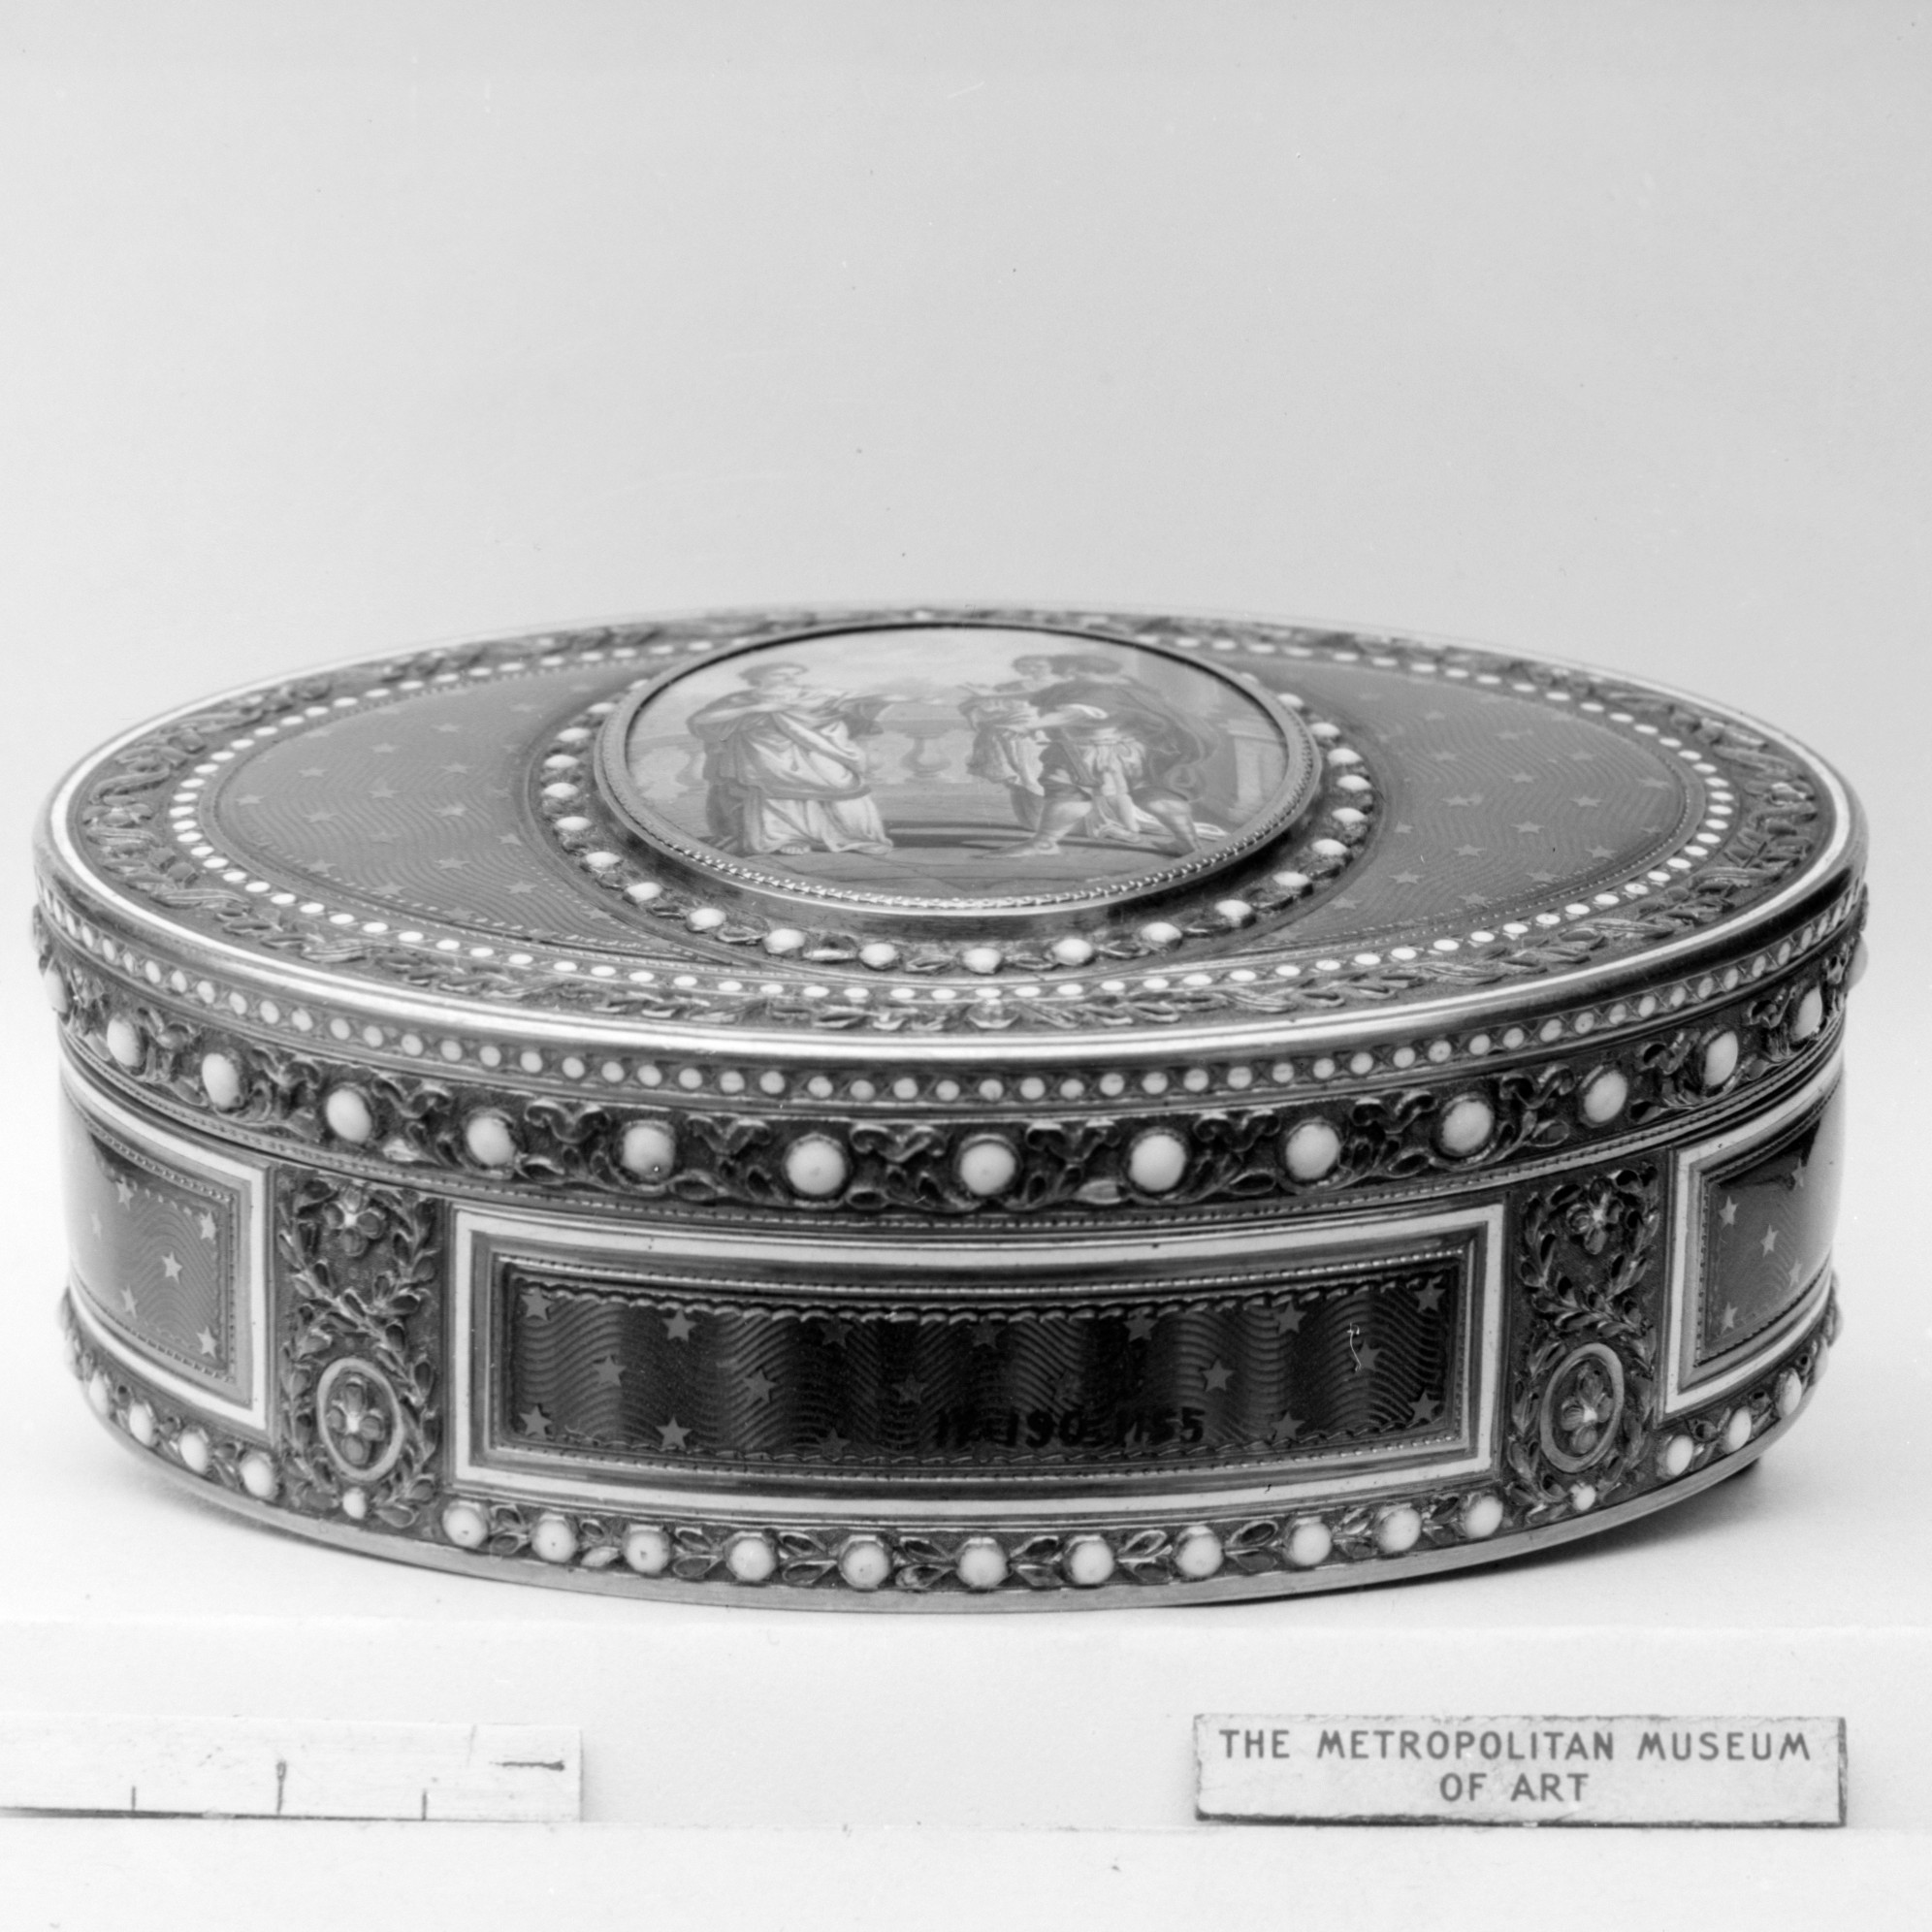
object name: snuffbox, painting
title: Snuffbox with miniature depicting a classical subject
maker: joseph etienne blerzy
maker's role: maker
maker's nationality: french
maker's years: 1750-1806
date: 1784-1785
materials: enamel, gold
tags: human figures